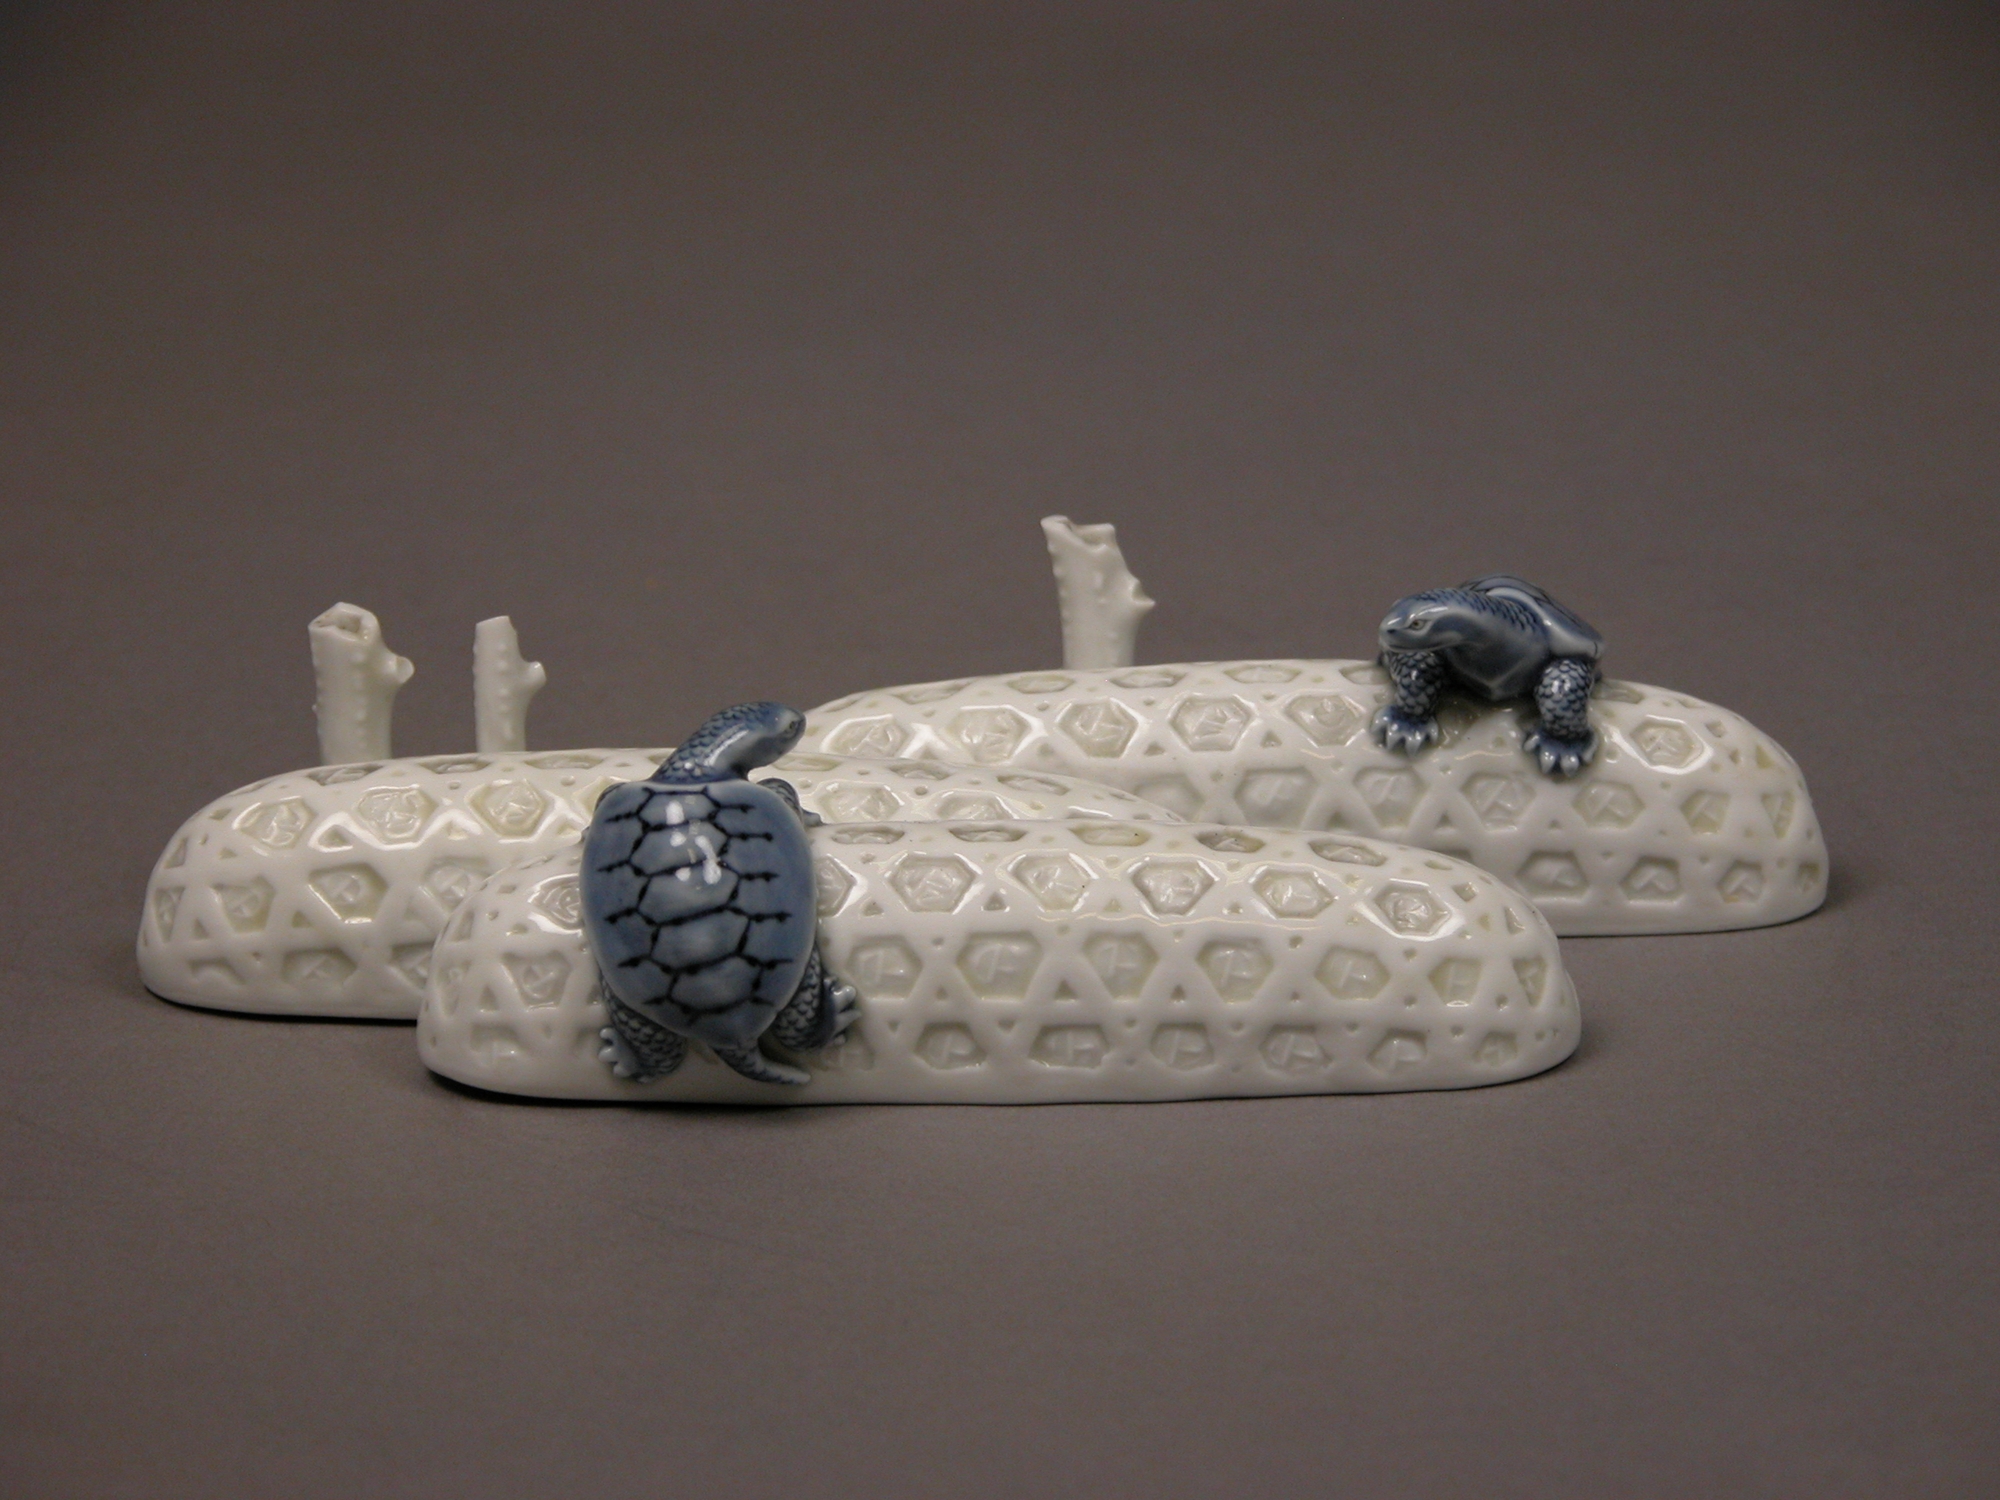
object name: paperweight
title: Paperweight in the Shape of Embankment Baskets and Turtles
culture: japanese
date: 1767-1833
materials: porcelain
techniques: underglaze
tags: turtles